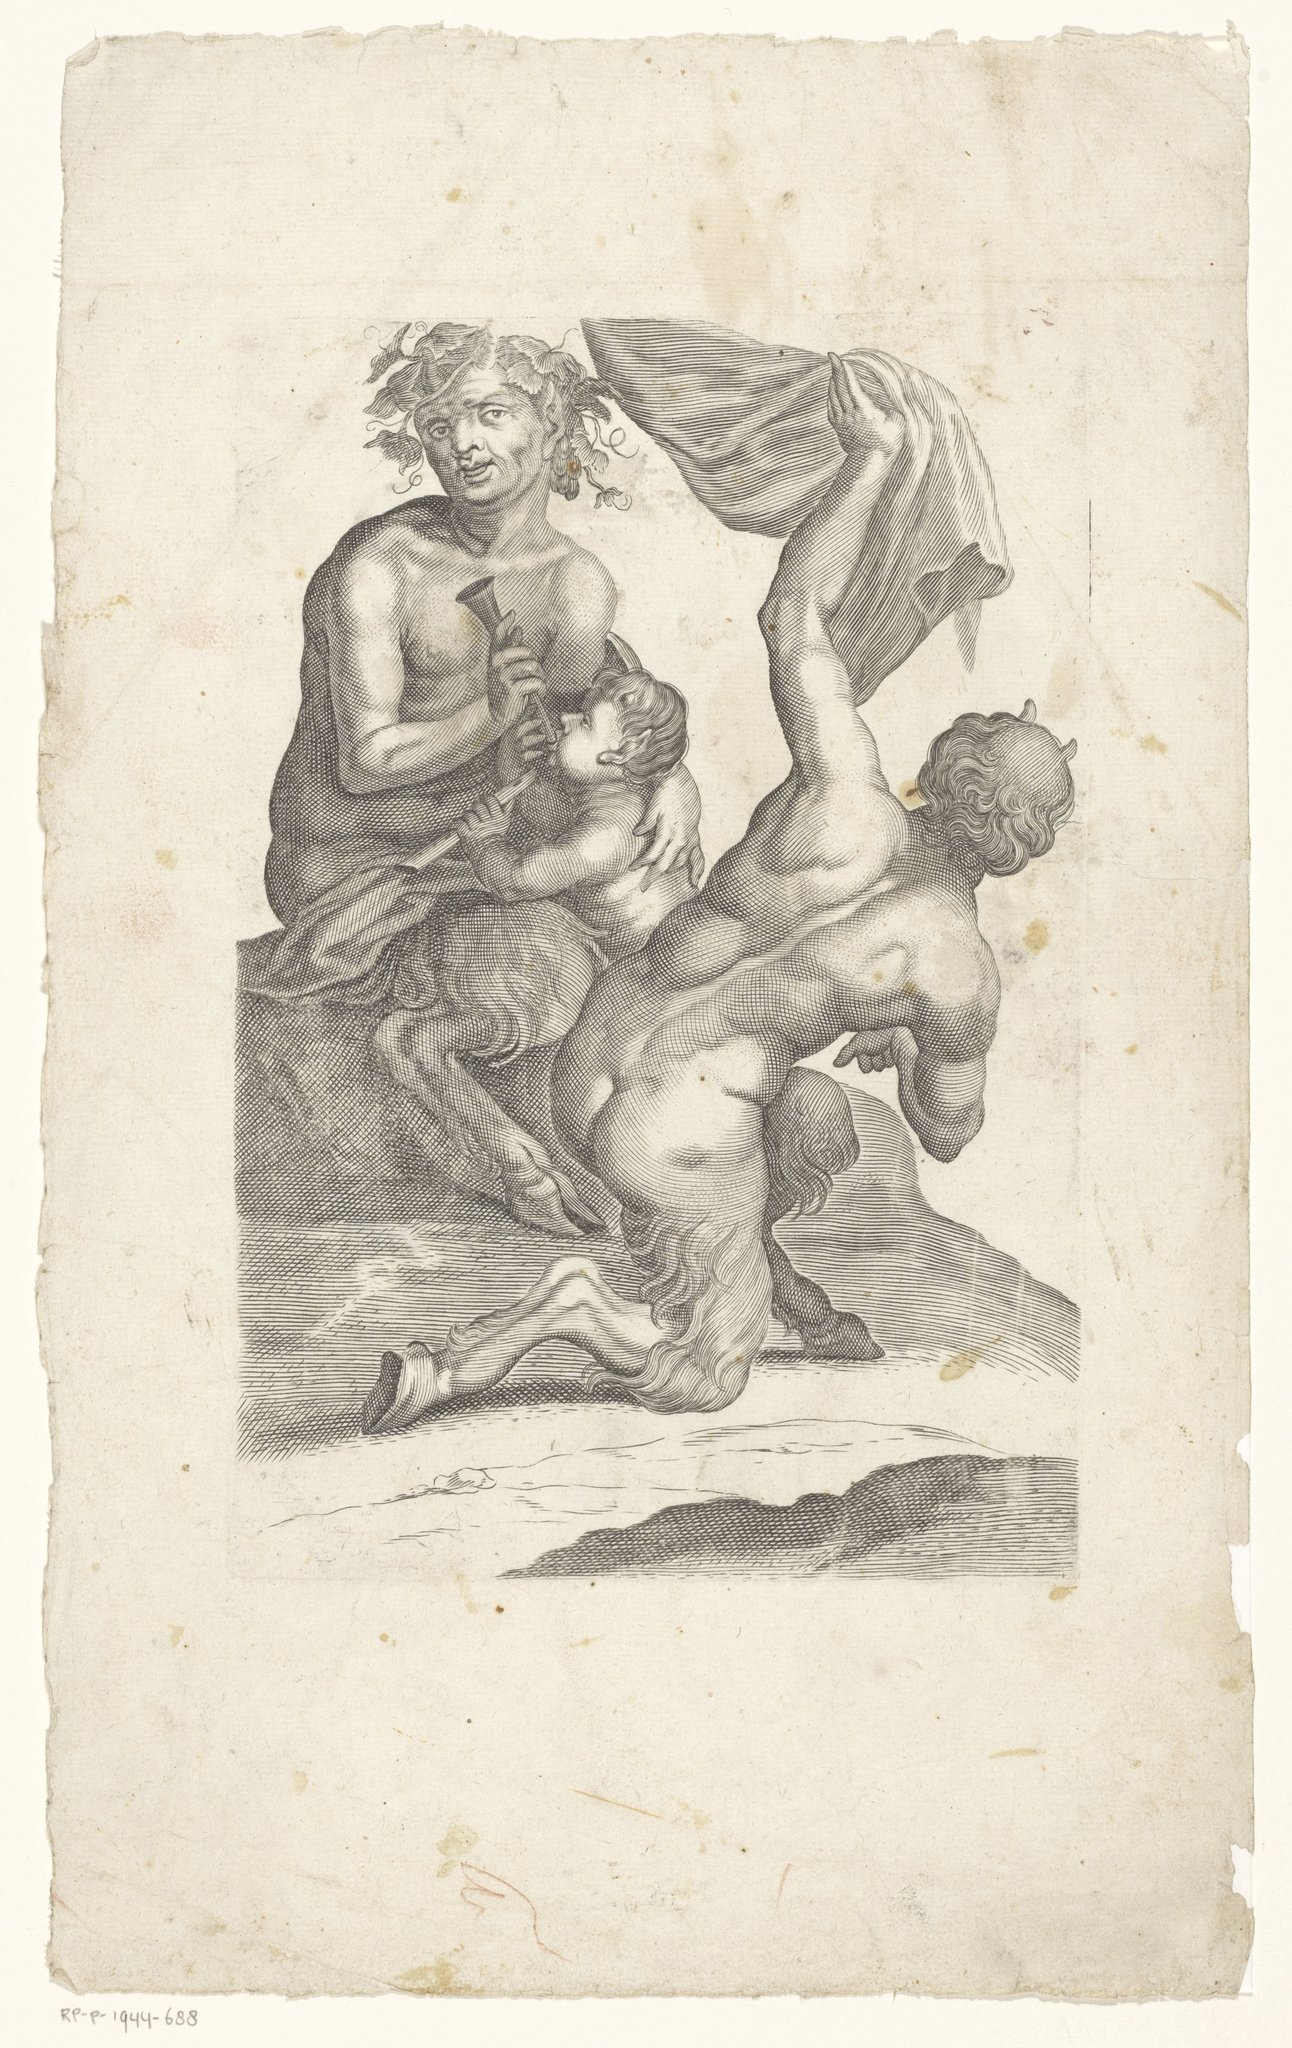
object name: print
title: Drie saters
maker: Anonymous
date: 1600-1699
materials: paper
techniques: engraving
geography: southern netherlands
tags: horn, trumpet, cornet, trombone, tuba, satyr(s) (in general), recorder (musical instrument)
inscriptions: collector's mark: Lugt 2228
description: Twee volwassen saters en een jonge sater. De jonge sater blaast op een trompet en houdt in zijn linkerhand een blokfluit vast.